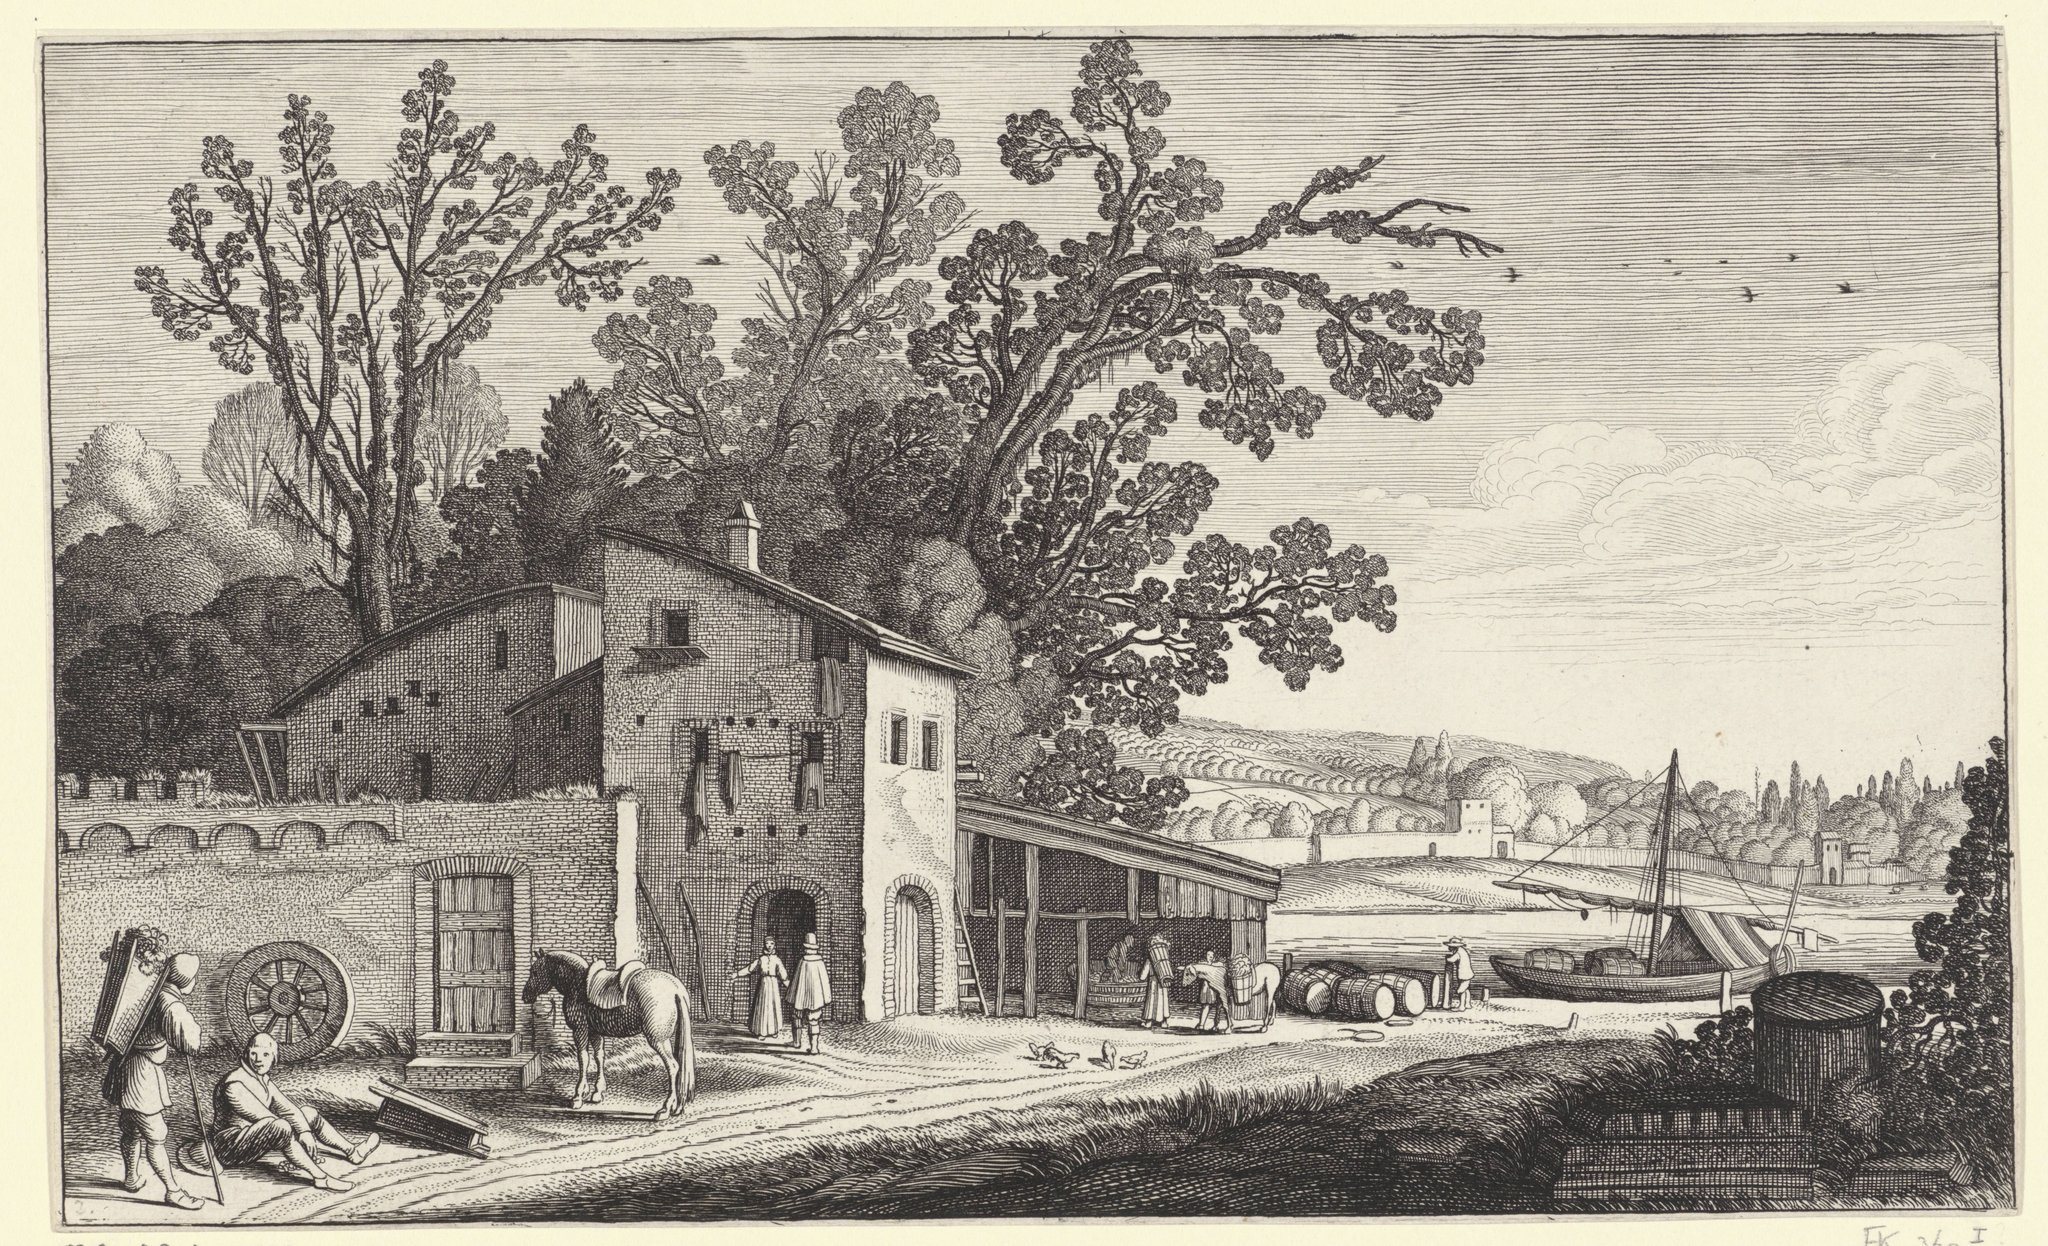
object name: print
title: Landschappen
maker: jan van de velde (ii)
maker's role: draughtsman, painter, print maker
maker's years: 1593-1641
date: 1603-1641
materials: paper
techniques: etching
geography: northern netherlands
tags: wooden container: barrel, cask, bucket, river, wine production, wine-press, traffic and transport (+ arrival, coming to anchor, at anchor)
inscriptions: number: ‘2’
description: Wijnmakerij in een landschap. Op de achtergrond een rivier en heuvels. Tweede prent van een serie van vier.